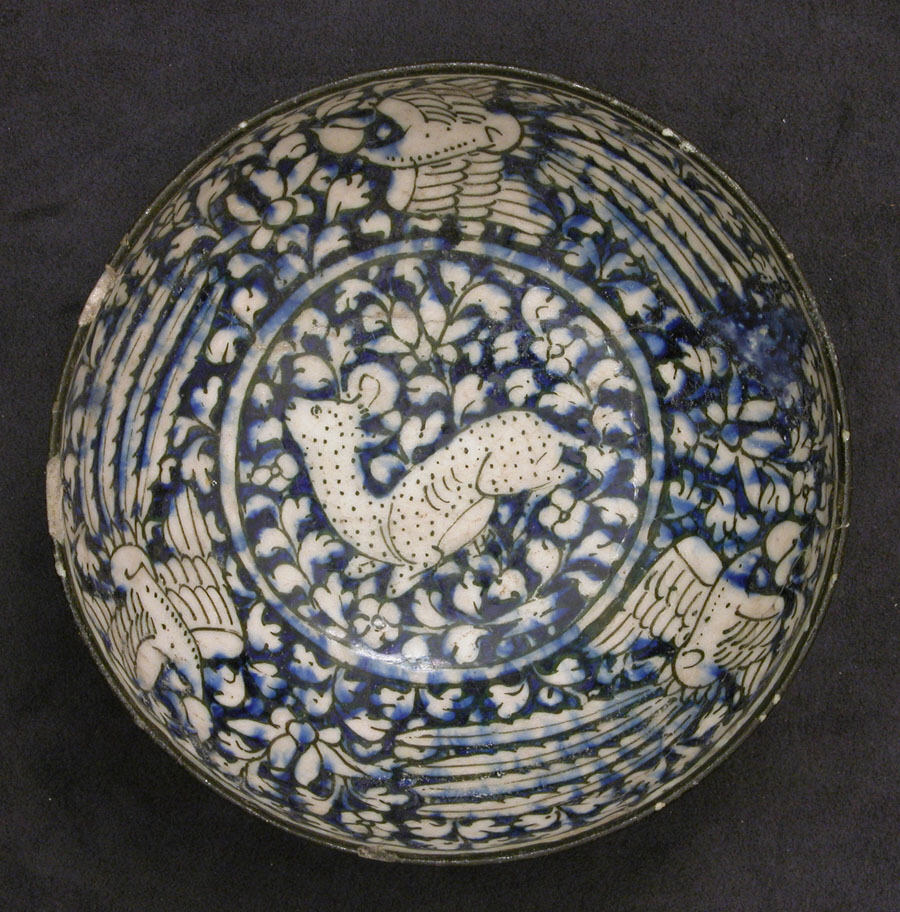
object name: bowl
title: Bowl with Deer and Phoenix Motifs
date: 1301-1350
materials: glaze, stonepaste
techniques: painting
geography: iran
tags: mythical creatures,deer